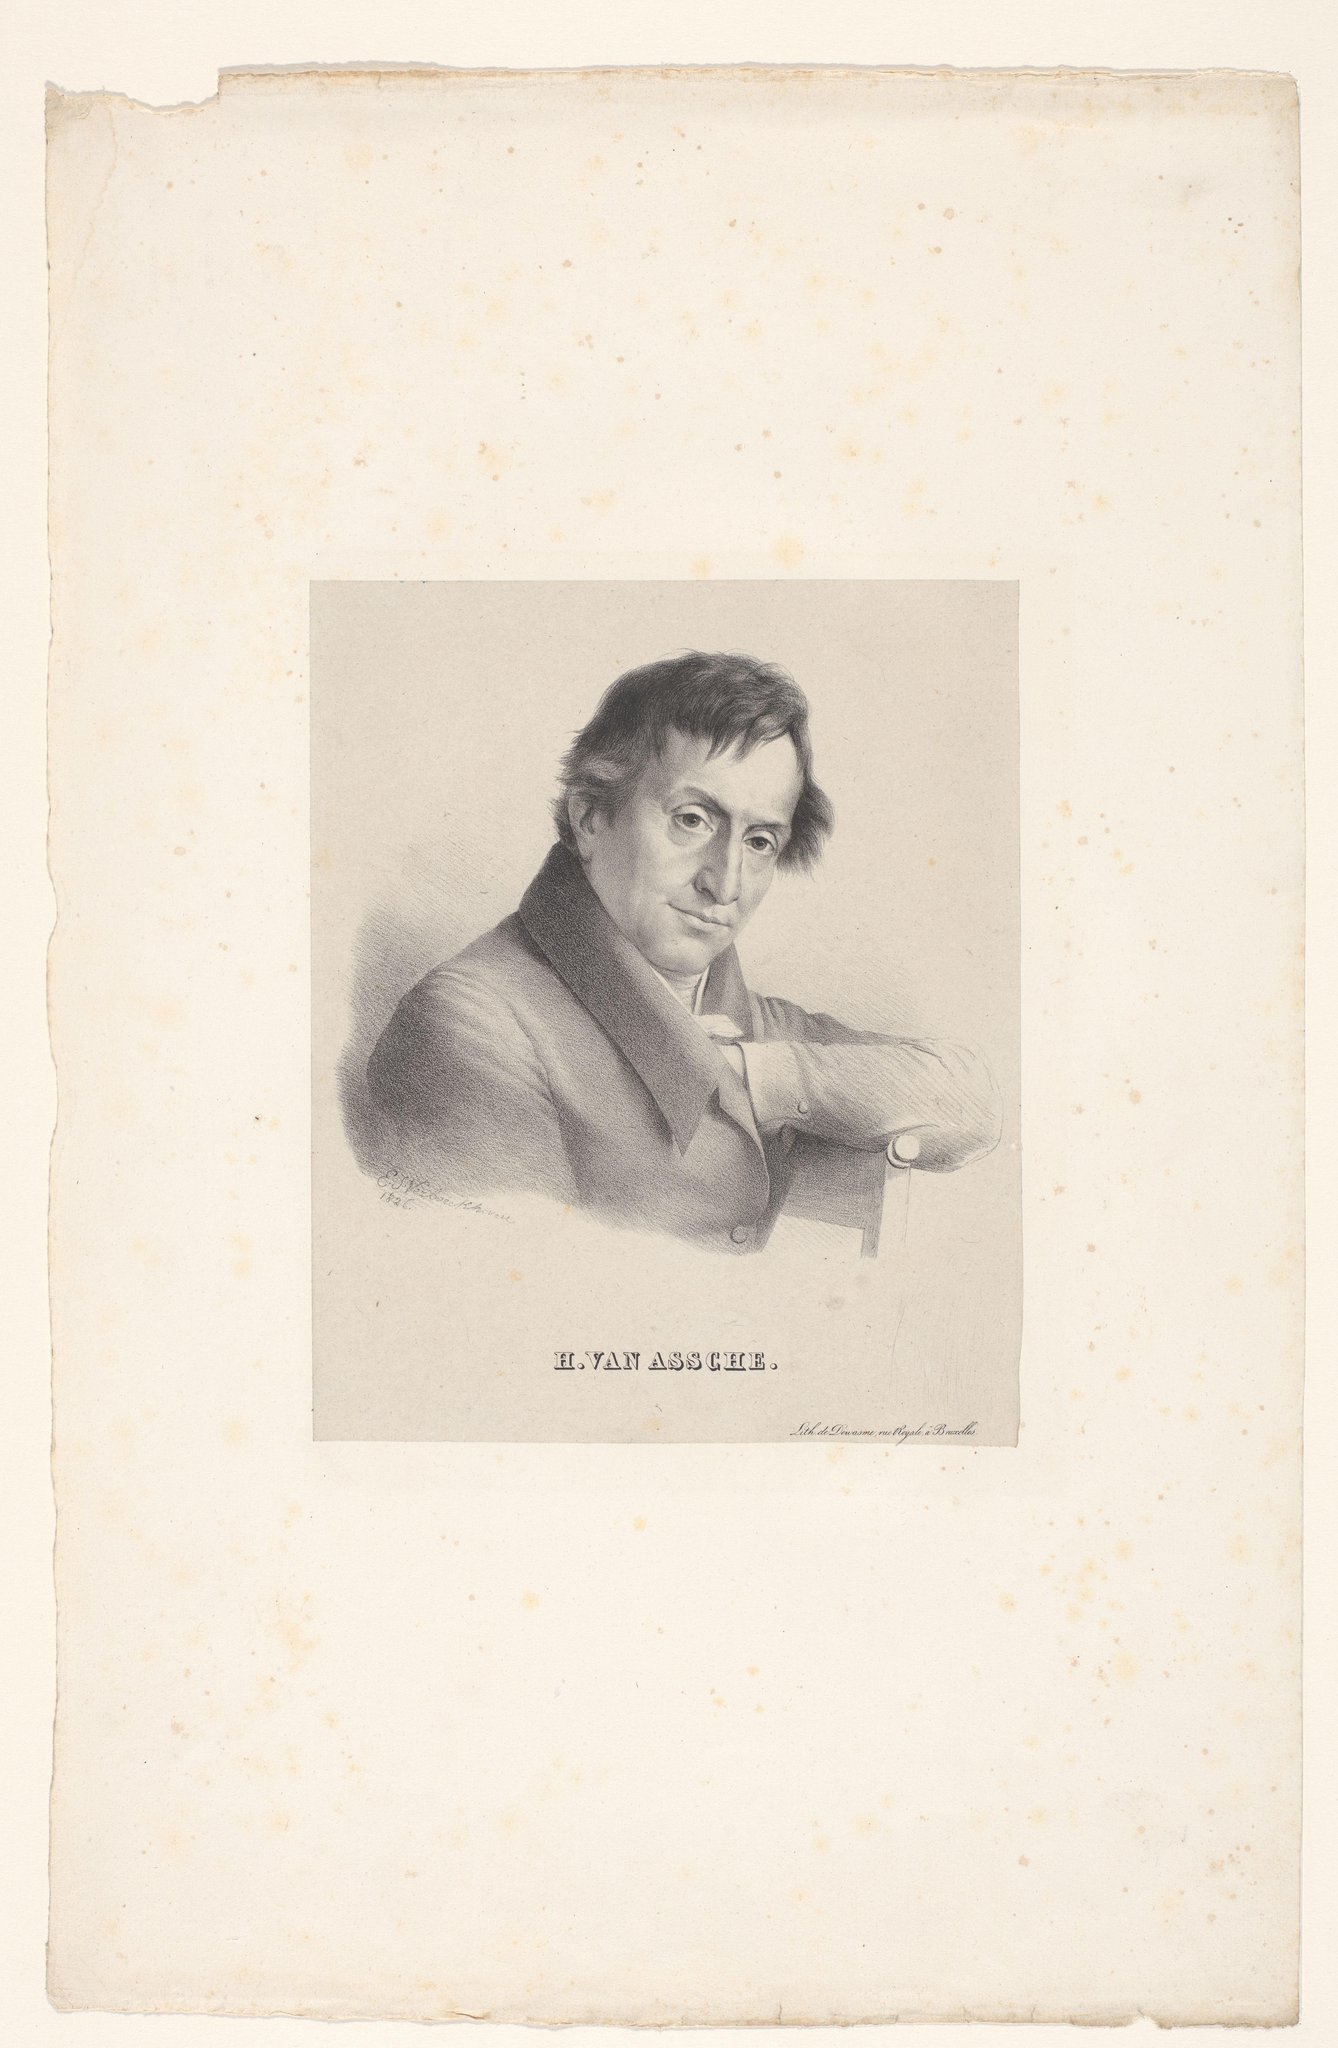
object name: print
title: H. van Assche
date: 1826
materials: paper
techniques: lithograph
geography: brussels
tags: print maker, henri van assche, historical persons, portrait, self-portrait of graphic artist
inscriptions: date